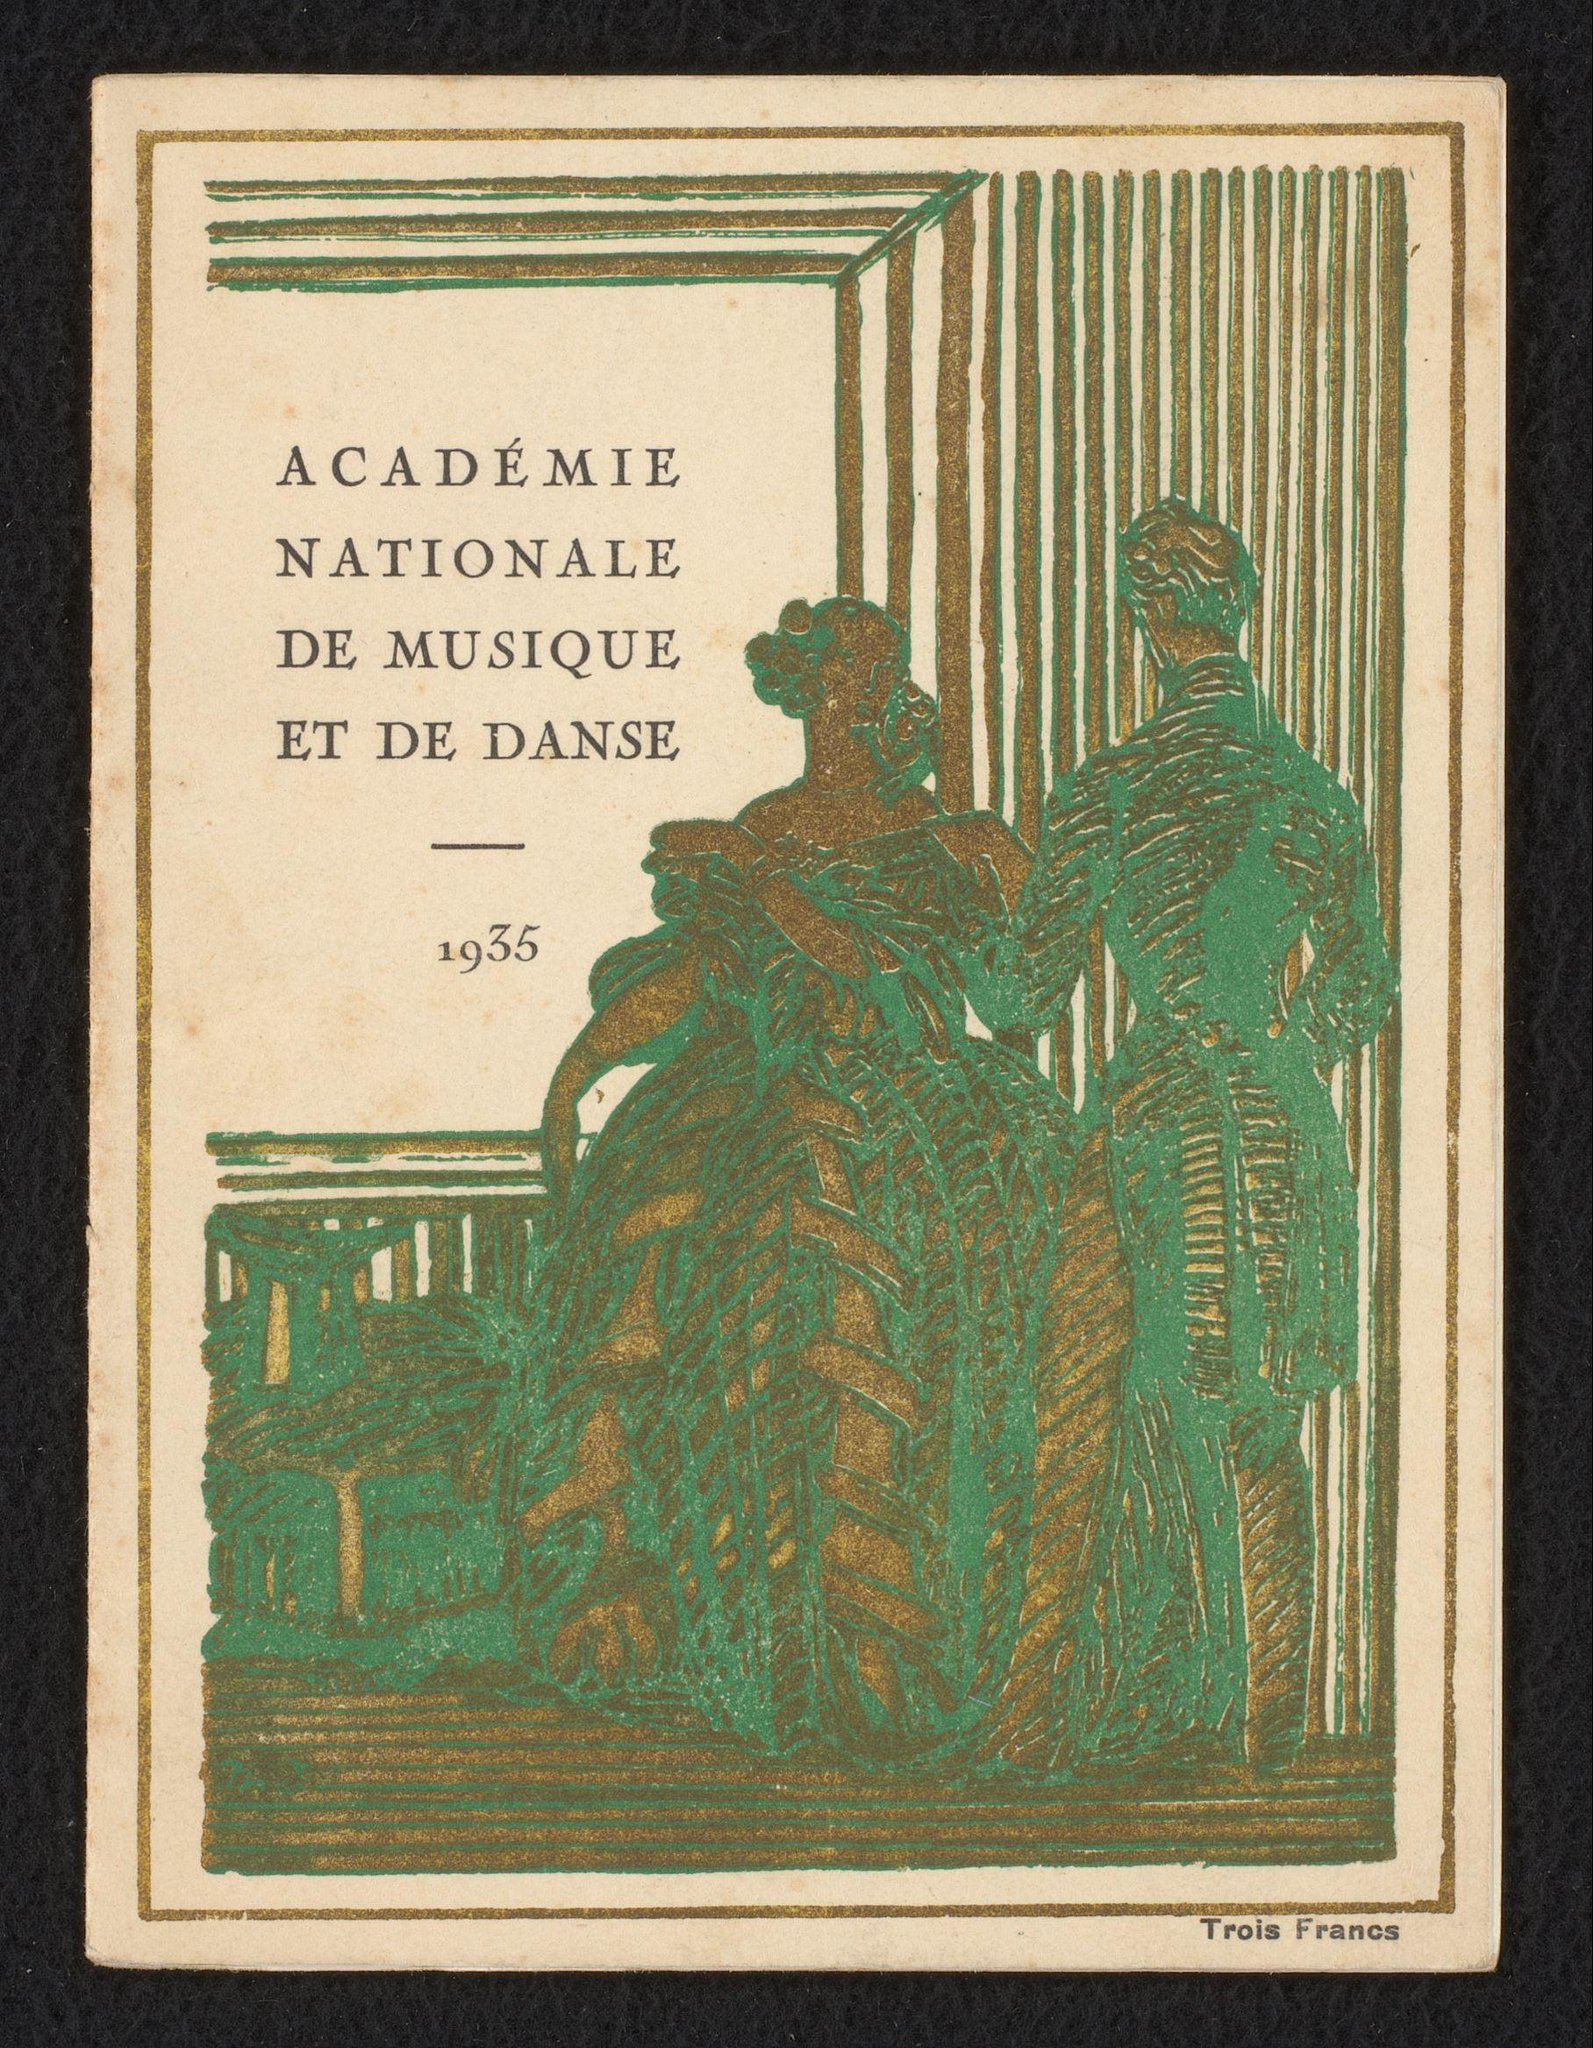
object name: programma, programmaboekje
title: Programma voor de voorstelling 'Thaïs' door de Académie Nationale de Musique et de Danse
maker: Anonymous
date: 1935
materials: paper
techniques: letterpress printing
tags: opera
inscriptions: date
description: Programma van 36 pagina's met op het omslag een man en een vrouw staand aan een balkon. Binnenin een tekst over het toneelstuk in het Frans en Engels, evenals portretten van de acteurs en advertenties.